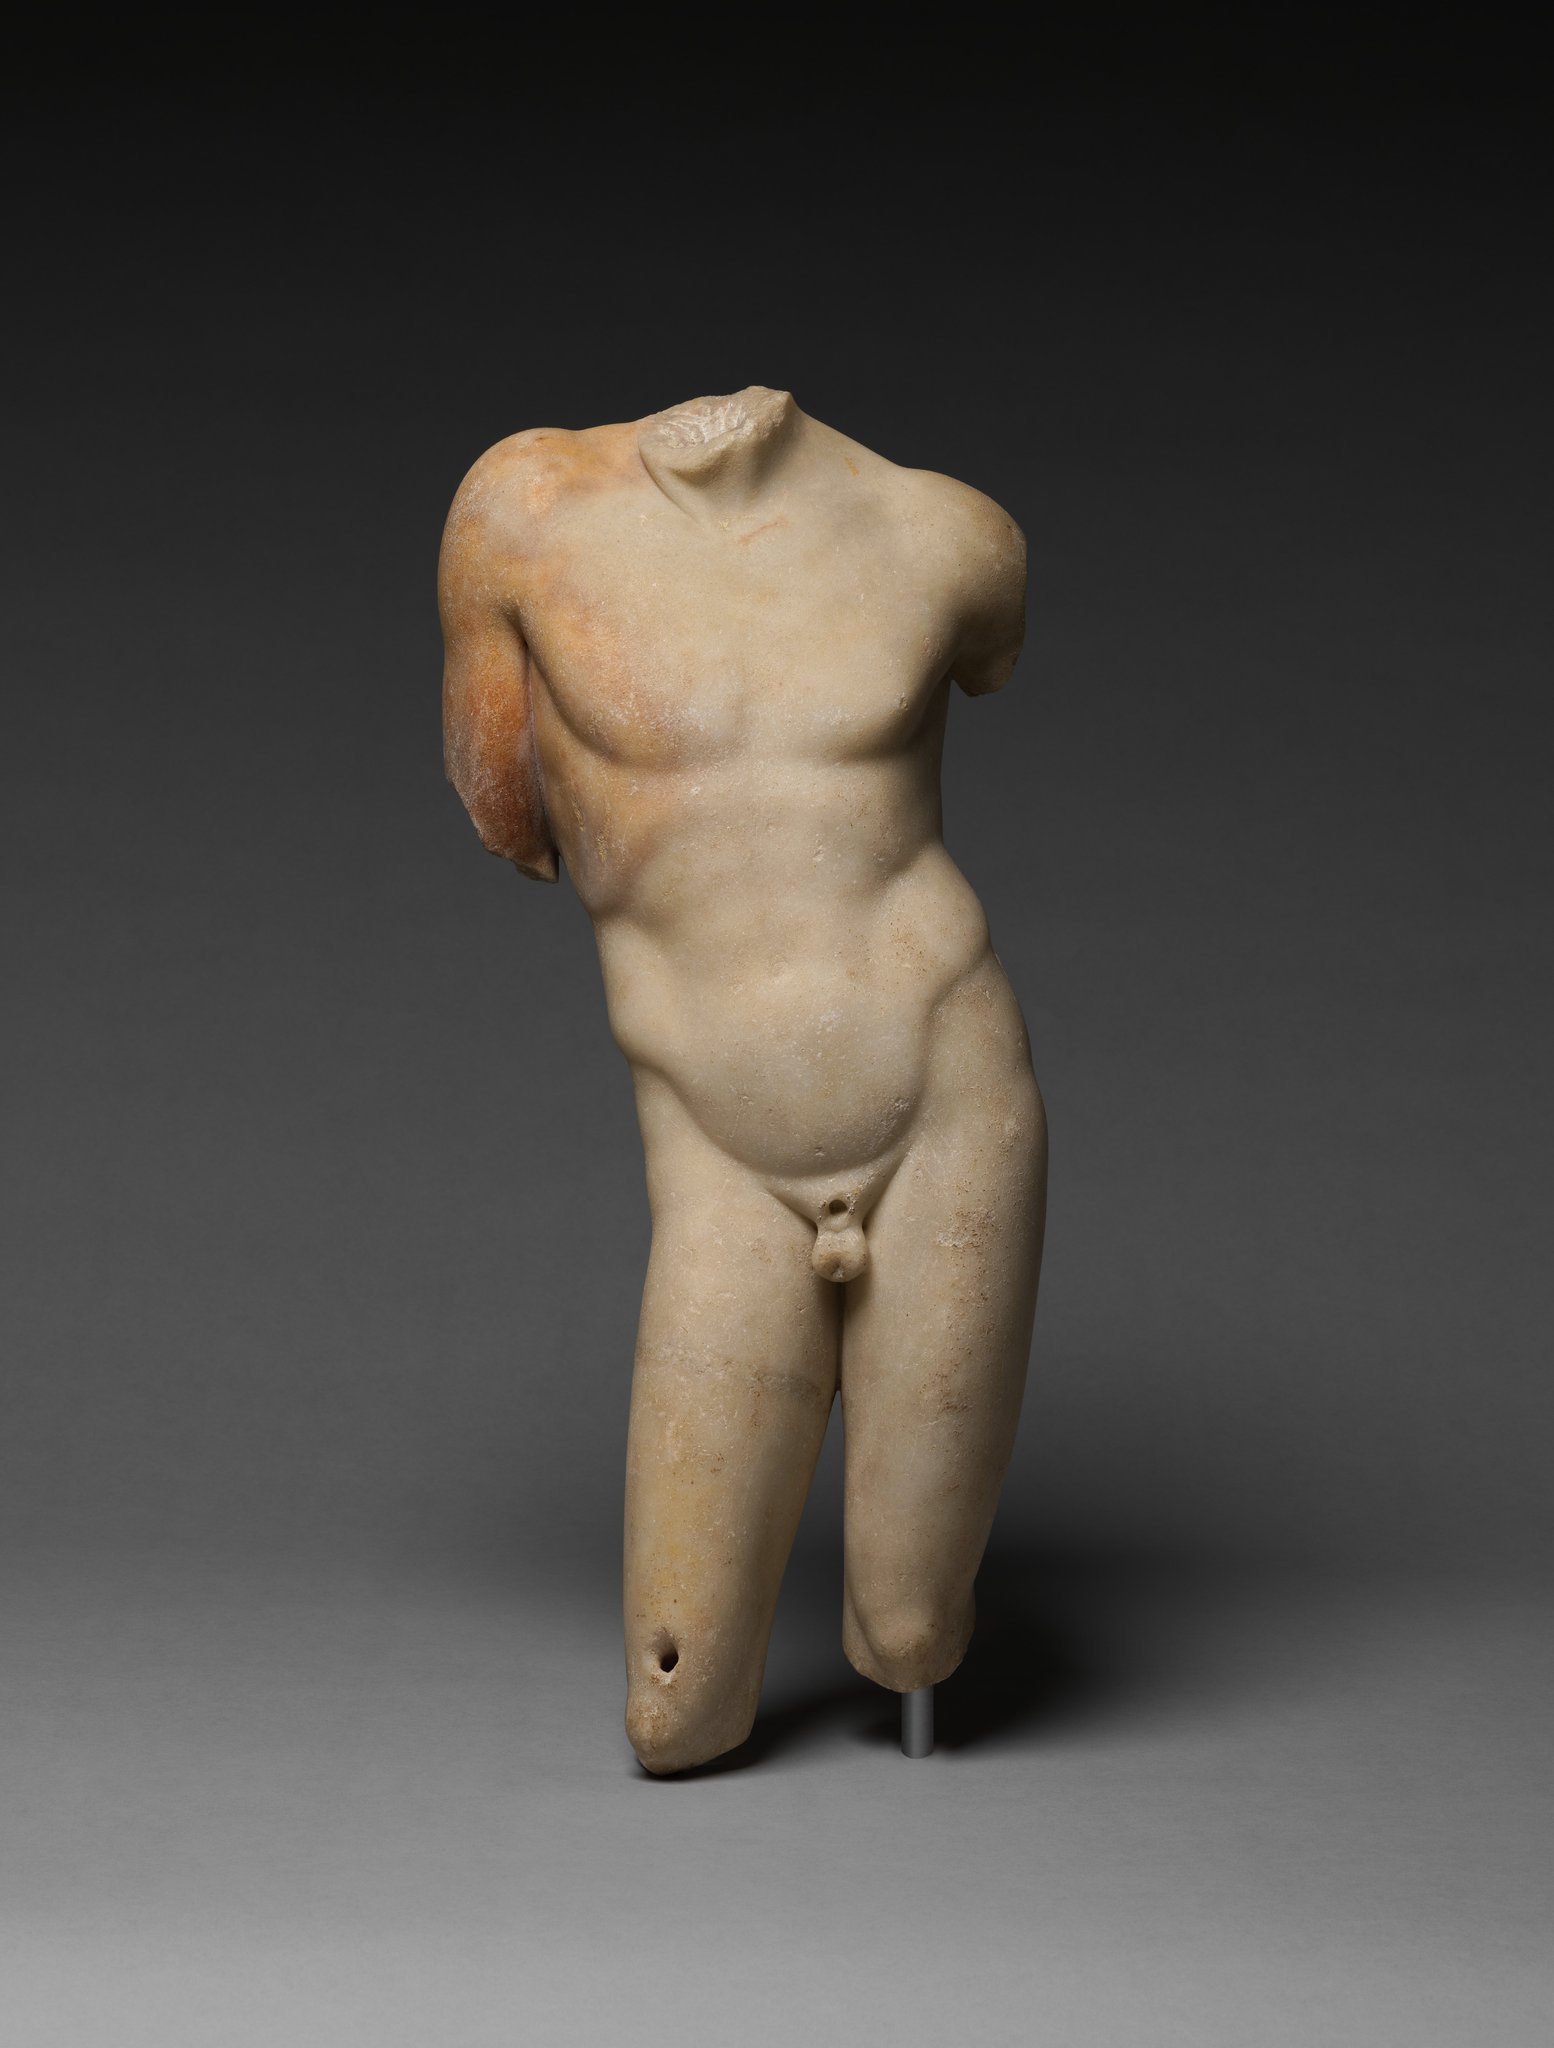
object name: torso of a boy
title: Marble torso of a boy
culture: roman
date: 1-200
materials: marble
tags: male nudes